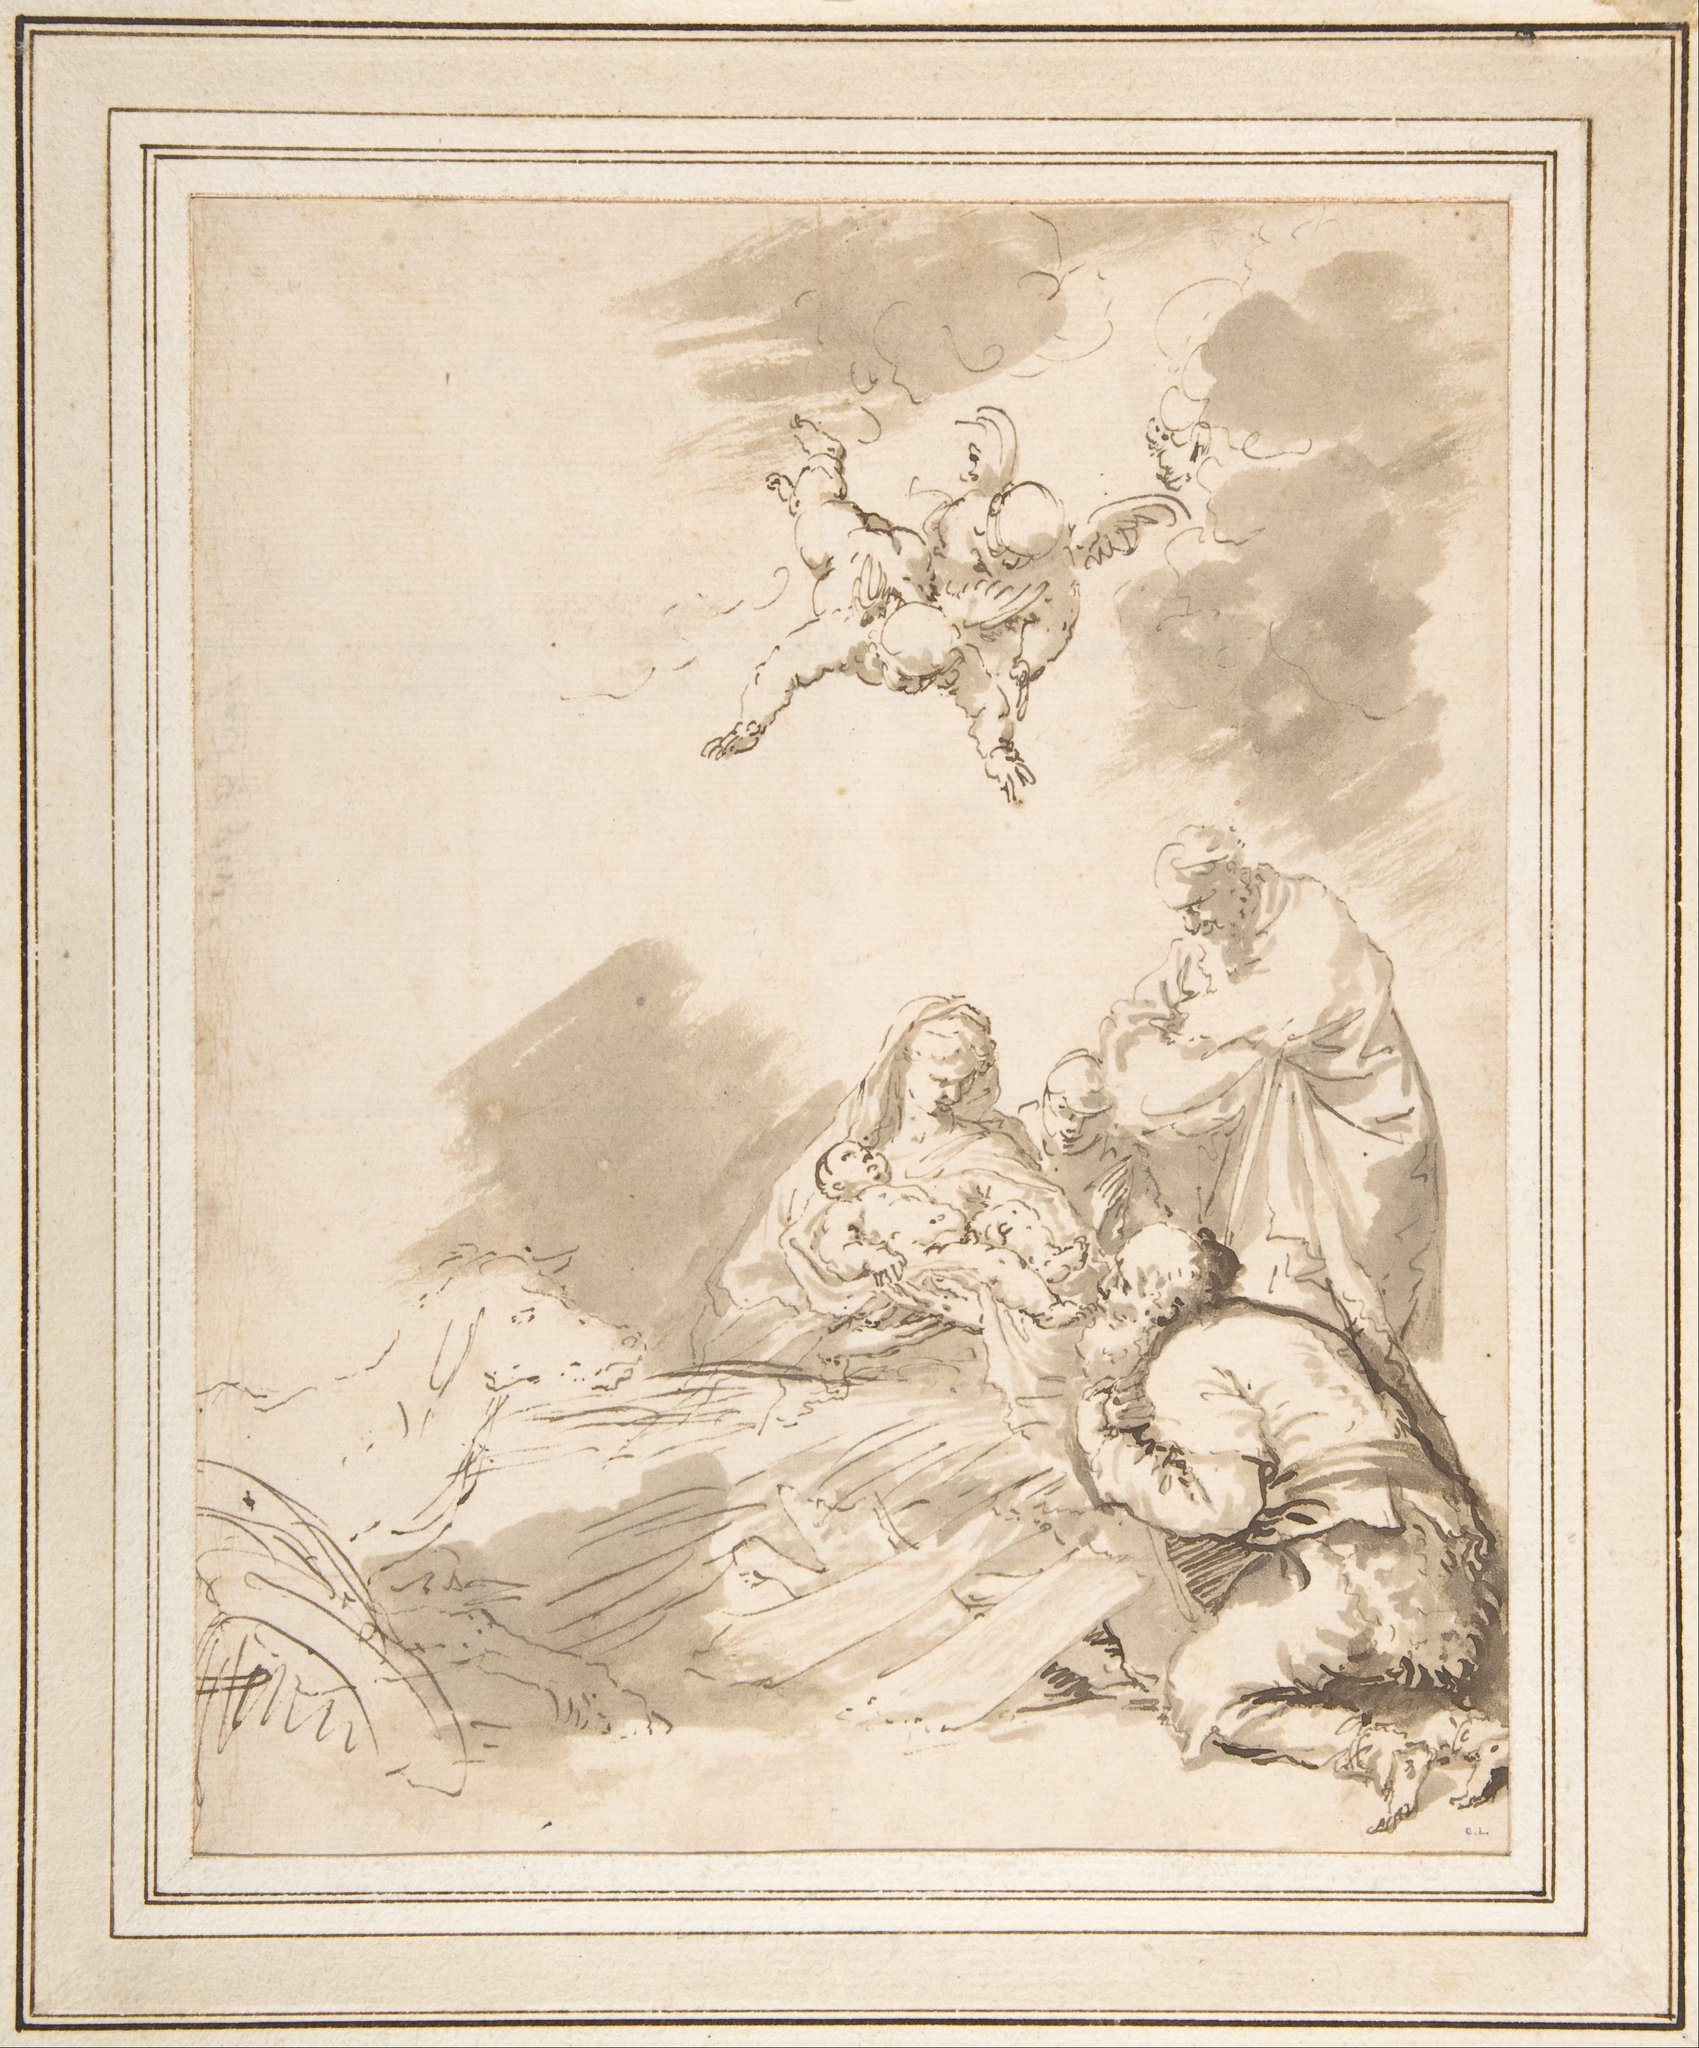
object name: drawing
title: Adoration of the Shepherds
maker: jusepe de ribera (called lo spagnoletto)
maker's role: artist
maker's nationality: spanish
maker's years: 1591-1652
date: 1645-1650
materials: ink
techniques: brush, pen, wash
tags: adoration of the shepherds